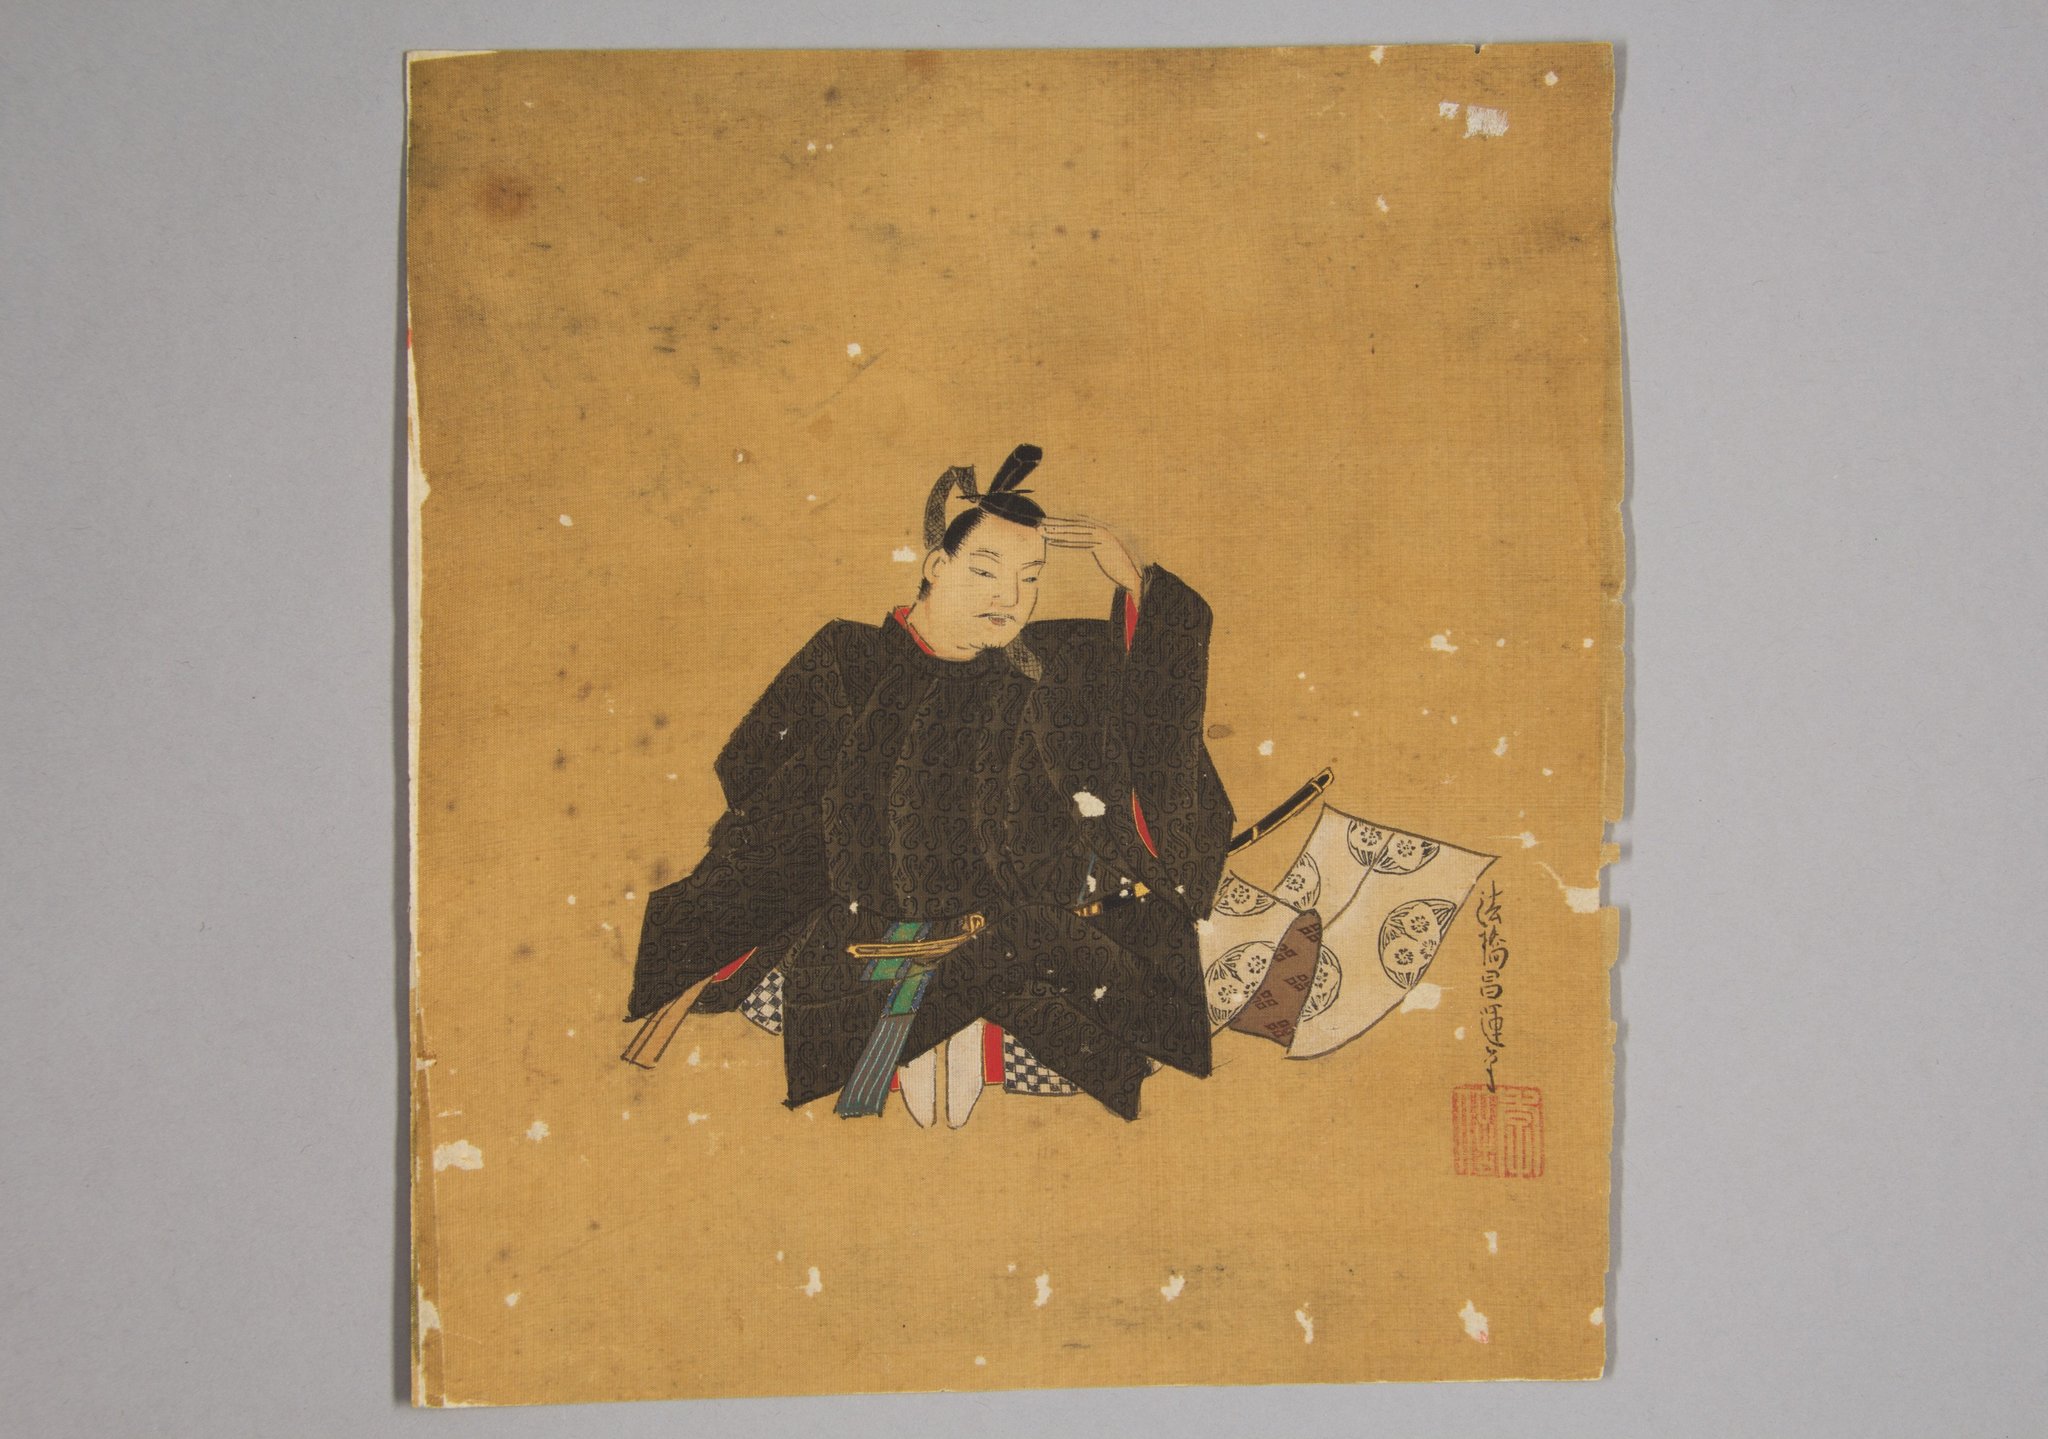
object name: painting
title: Immortal Poet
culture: japanese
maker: kano shōun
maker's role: artist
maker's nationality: japanese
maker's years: 1637-1702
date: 1601-1700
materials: ink, silk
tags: men,poets